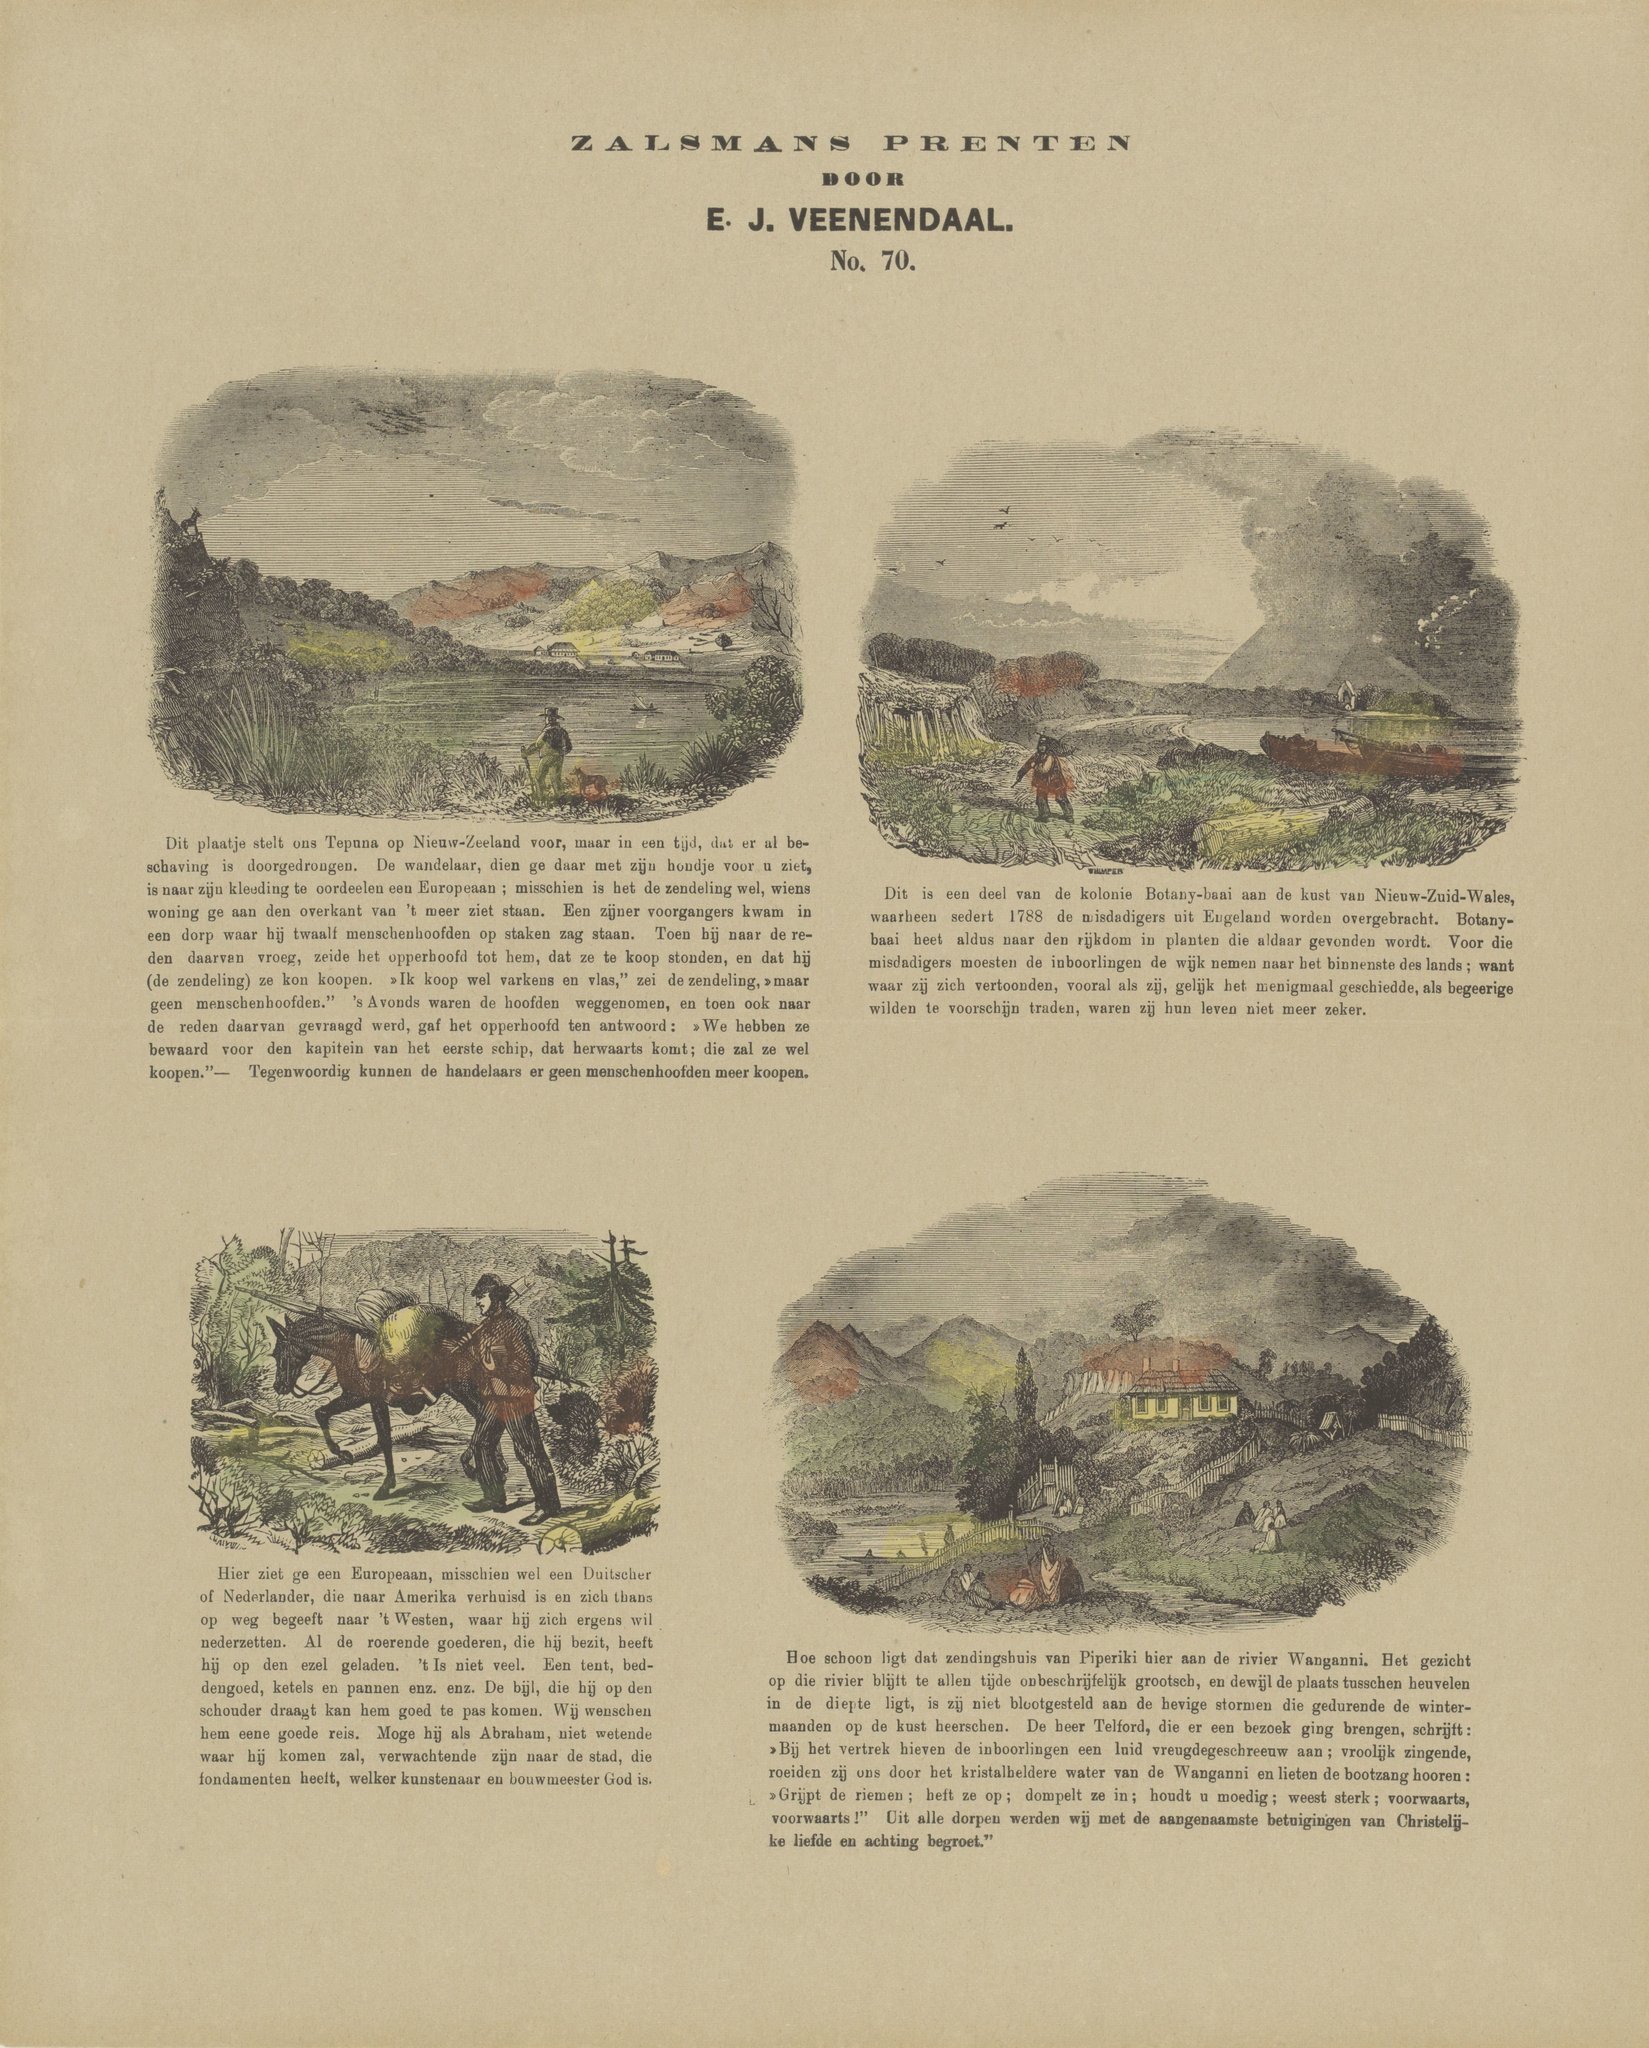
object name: popular print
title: Gezichten van Amerika, Nieuw-Zeeland en Canada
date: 1869-1882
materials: paper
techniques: colour, letterpress printing, engraving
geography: netherlands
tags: landscapes, canada, australia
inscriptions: collector's mark: Lugt 2760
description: Blad met 4 voorstellingen van gezichten van Amerika, Nieuw-Zeeland en Canada. Onder elke afbeelding een onderschrift. Genummerd midden boven: No. 70.